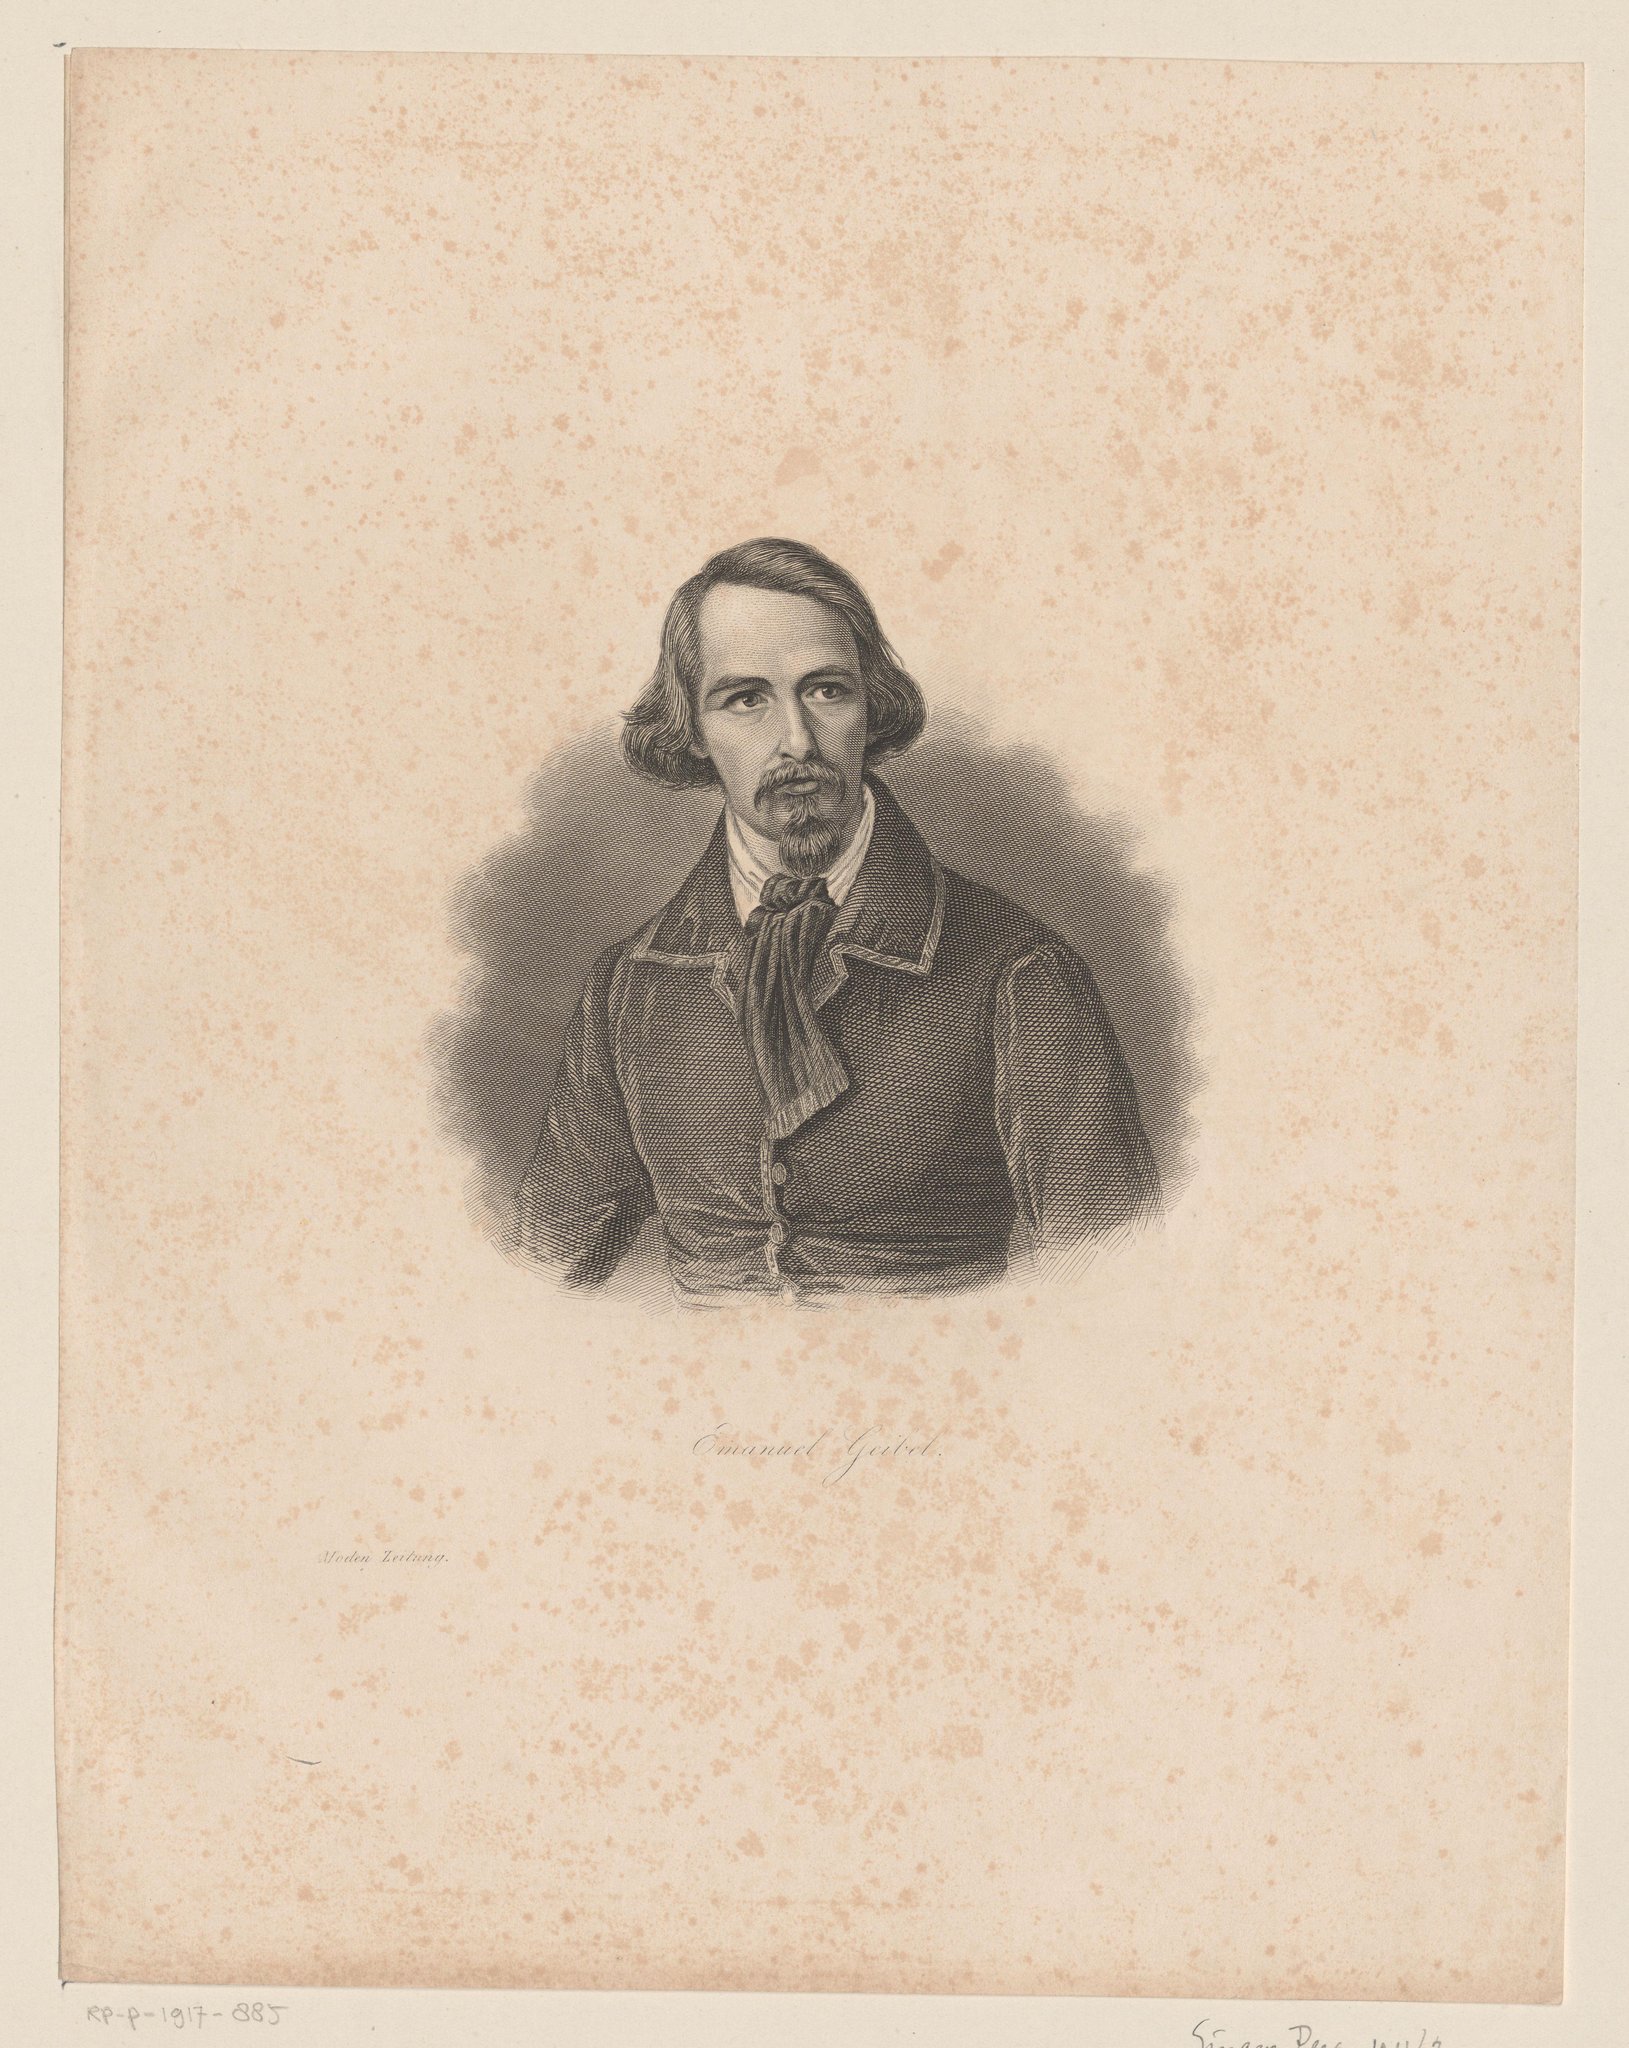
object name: print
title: Portret van Emmanuel Geibel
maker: Anonymous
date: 1845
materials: paper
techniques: engraving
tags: historical persons, lawyer, attorney at law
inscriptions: collector's mark: Lugt 2228